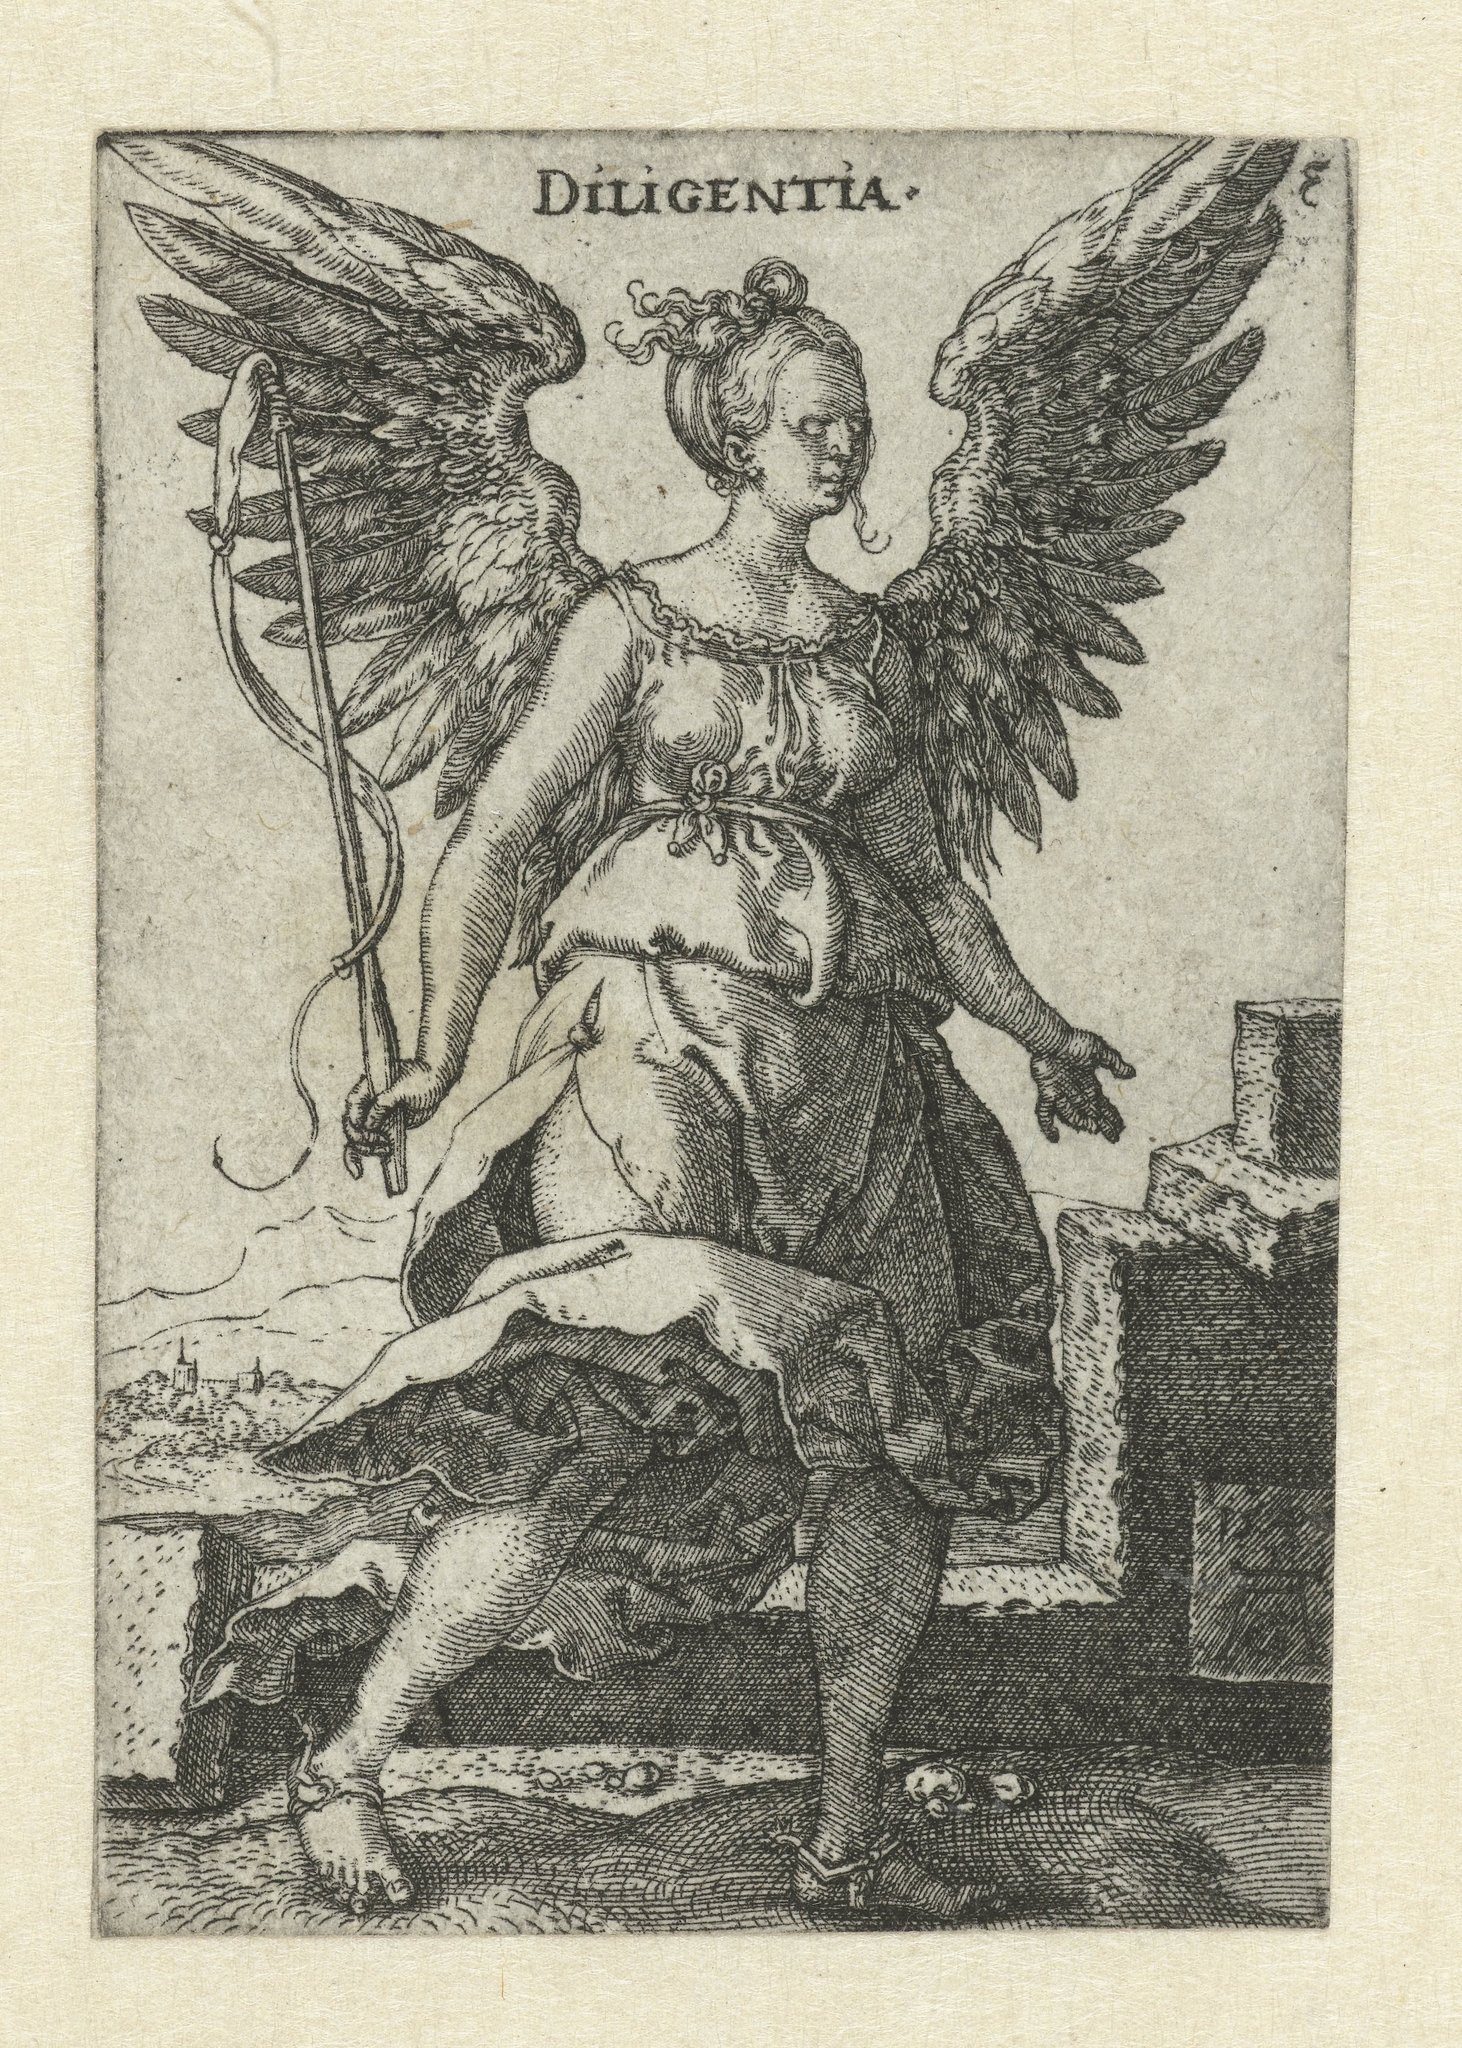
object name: print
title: Diligentia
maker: heinrich aldegrever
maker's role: draughtsman, print maker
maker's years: 1502-1561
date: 1549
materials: paper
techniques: engraving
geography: germany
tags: carefulness, diligence; 'diligenza' (ripa) (+ abstract concept represented by female figure)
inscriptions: date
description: Personificatie van de vlijt (Diligentia). Een vrouw met vleugels, staand met een zweep in haar rechterhand. Derde prent uit een serie van veertien met personificaties van deugden en ondeugden.